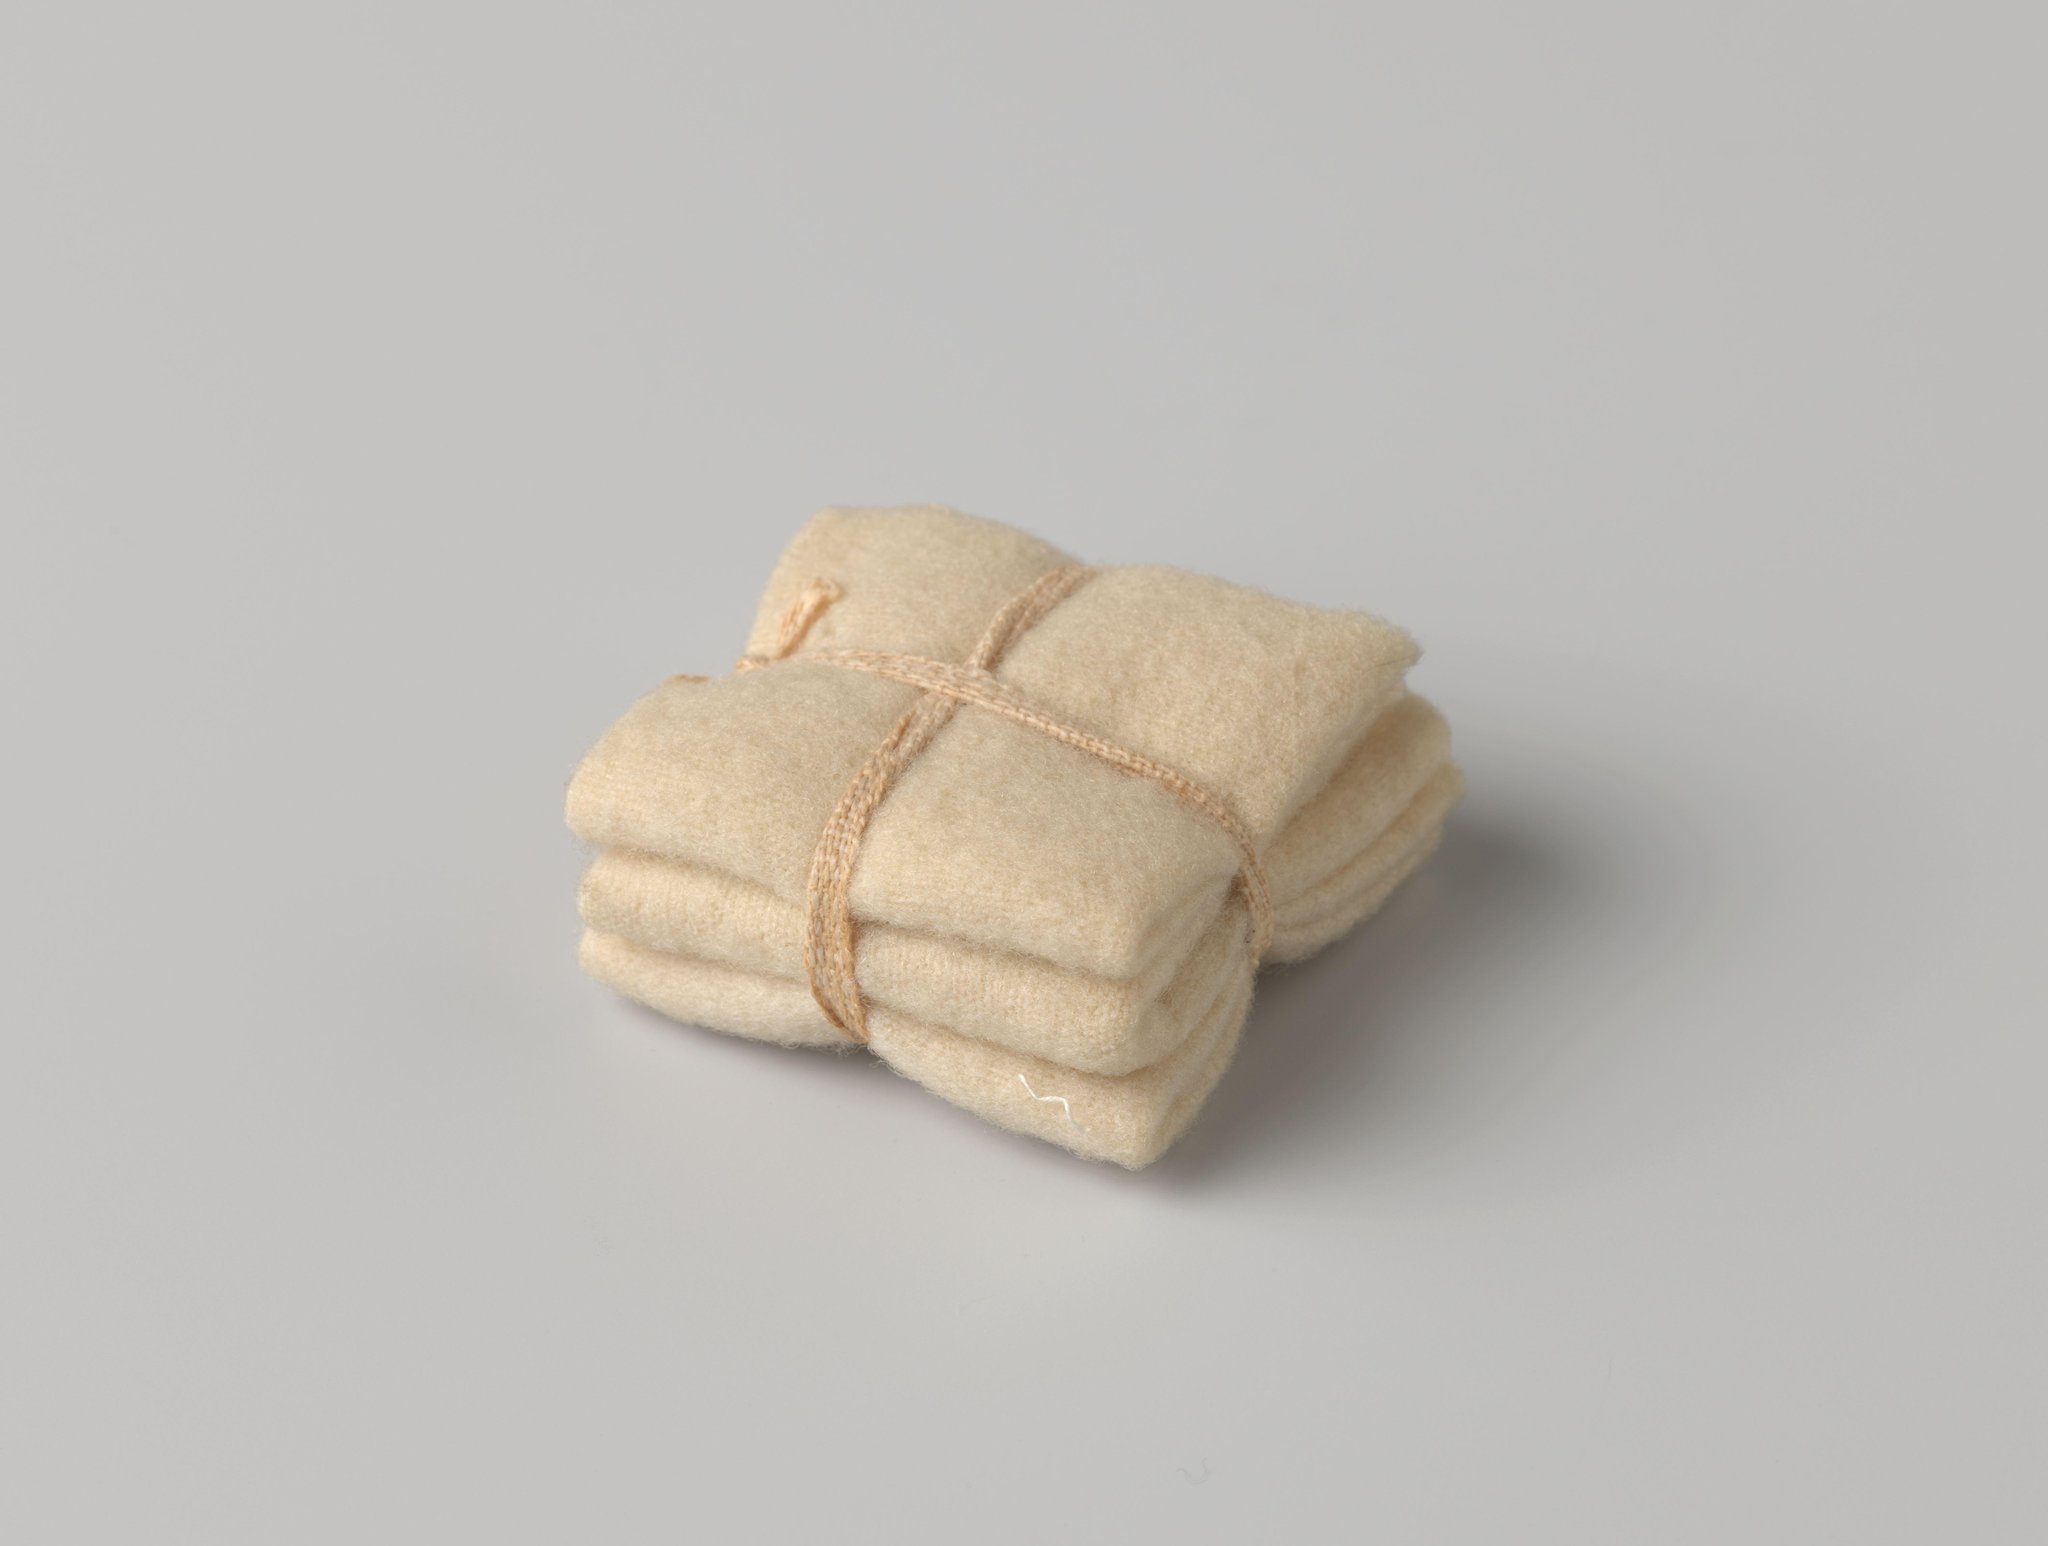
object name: miniature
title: Stapel dekens, samengebonden met een band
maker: Anonymous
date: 1750-1800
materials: linen, wool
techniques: napping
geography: netherlands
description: Een stapel van drie opgevouwen en samengebonden wollen dekens (?) gebundeld met linnen band.